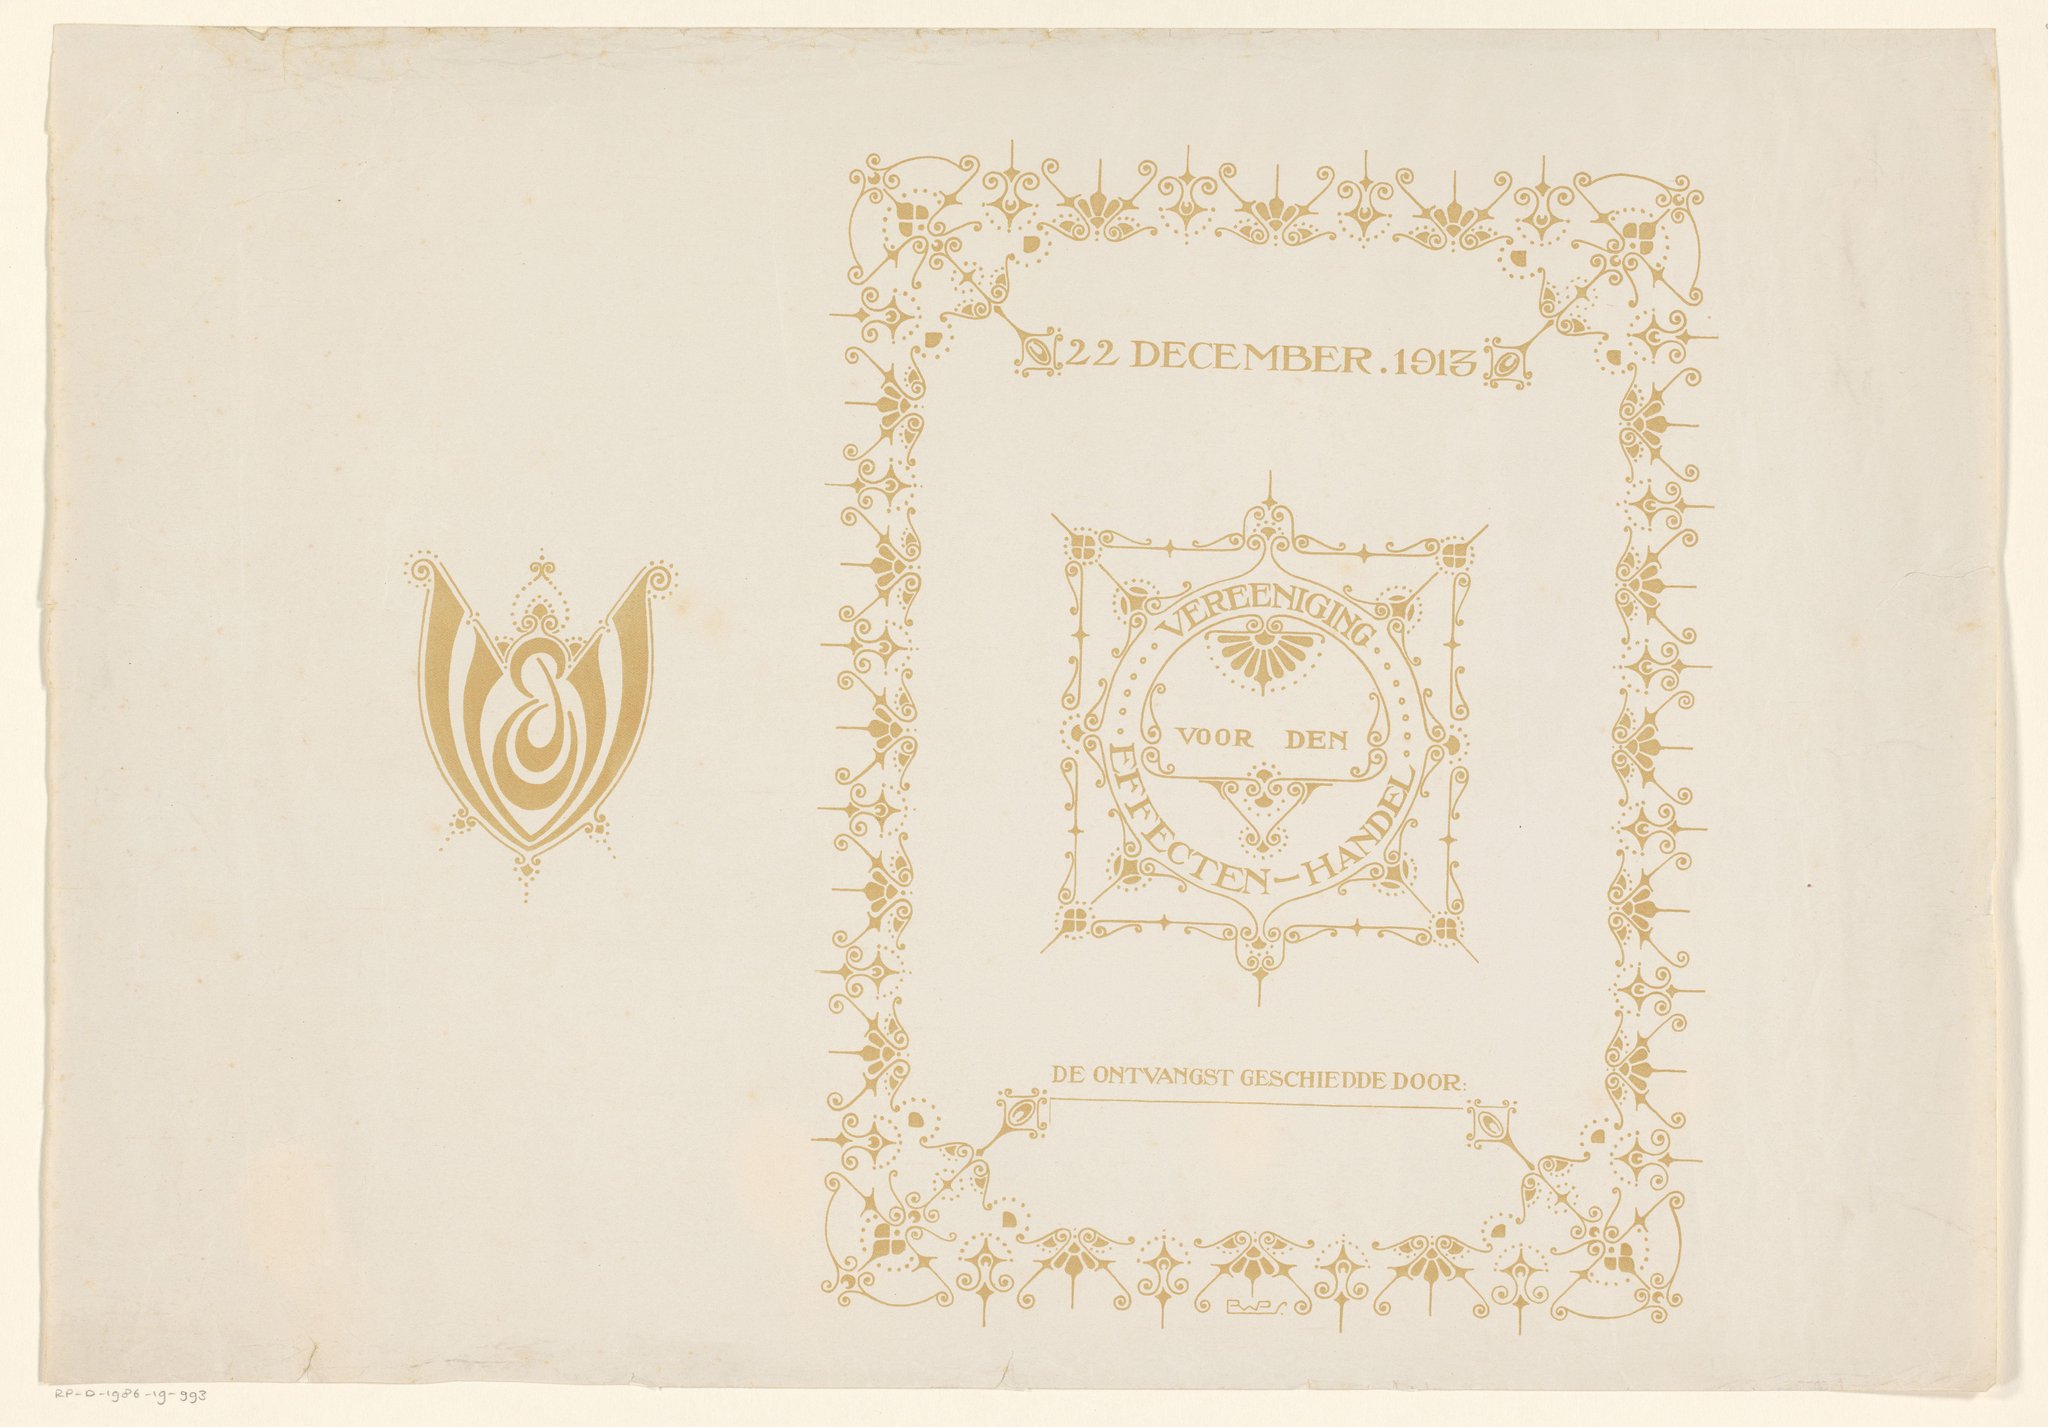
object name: design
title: Ontwerp met bladdecoratie voor de Vereeniging voor den Effectenhandel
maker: reinier willem petrus de vries (1874-1953)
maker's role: draughtsman, print maker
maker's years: 1874-1953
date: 1913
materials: paper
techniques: lithograph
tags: flowers ~ ornament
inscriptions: collector's mark: ‘R:MVS.’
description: Ontwerp, mogelijk voor een album of omslag, met links het beeldmerk van de vereniging en rechts een rechthoekig kader met bloemornamenten met daarin een vierkant kader met tekst en bloemornamenten.